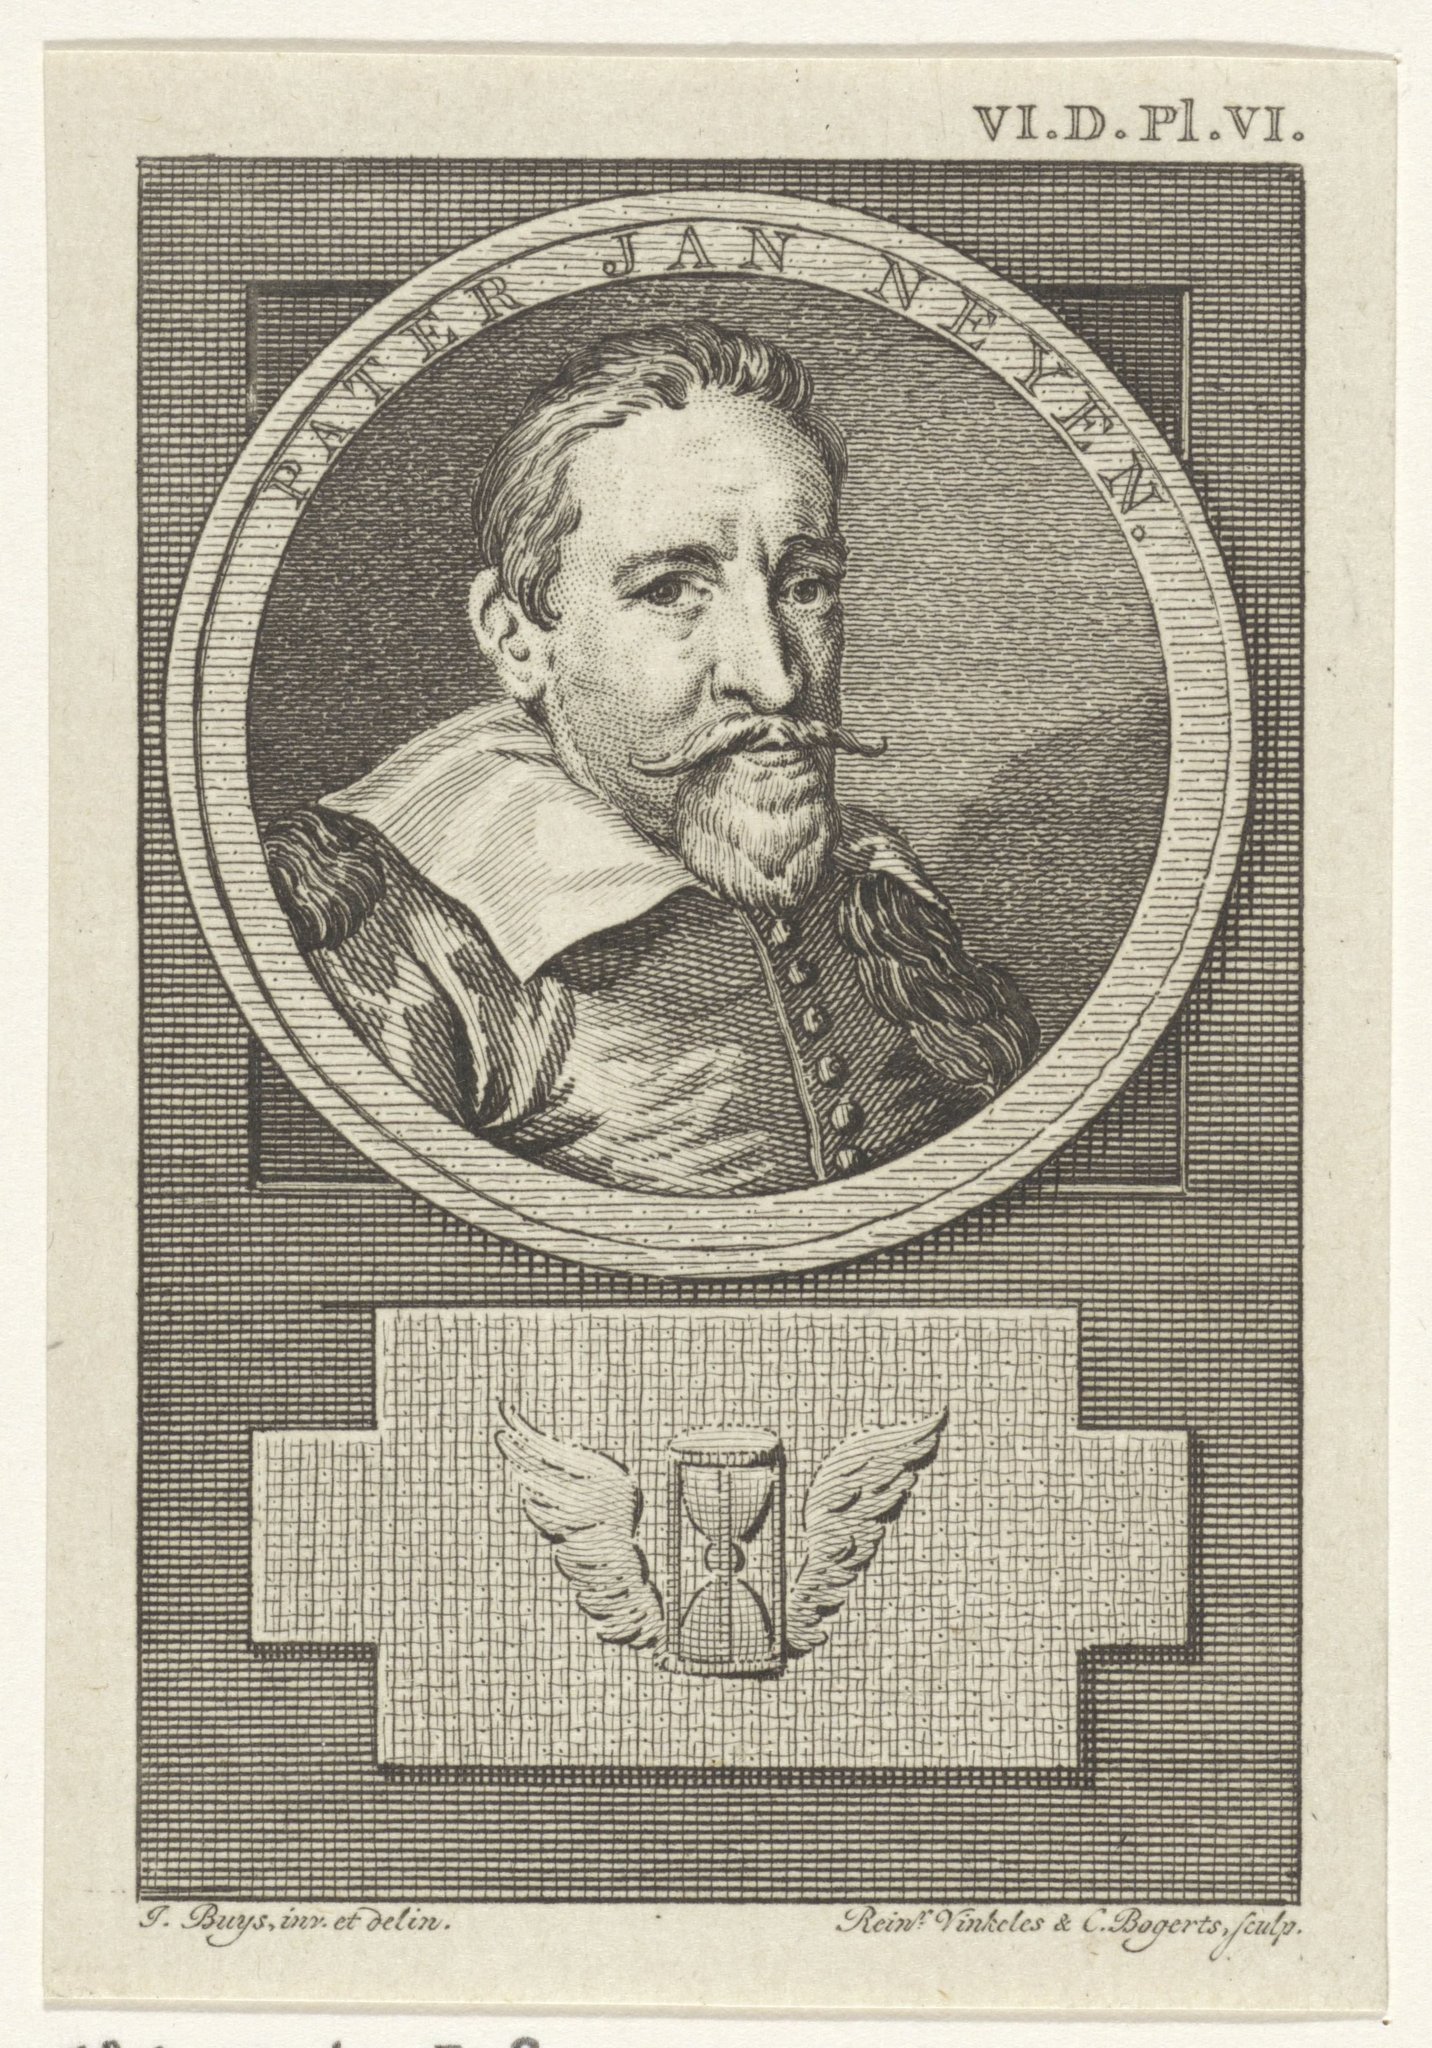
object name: book illustration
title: Portret van Jan Neyen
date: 1783-1795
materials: paper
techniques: engraving, etching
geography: amsterdam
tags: antwerp, hourglass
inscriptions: collector's mark: Lugt 2228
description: Prent gebruikt in: Fokke, Jan. Geschiedenissen der Vereenigde Nederlanden voor de vaderlandsche jeugd Ie-XXVste deel. Amsterdam: Johannes Allart, 1783-1795. Deel VI.